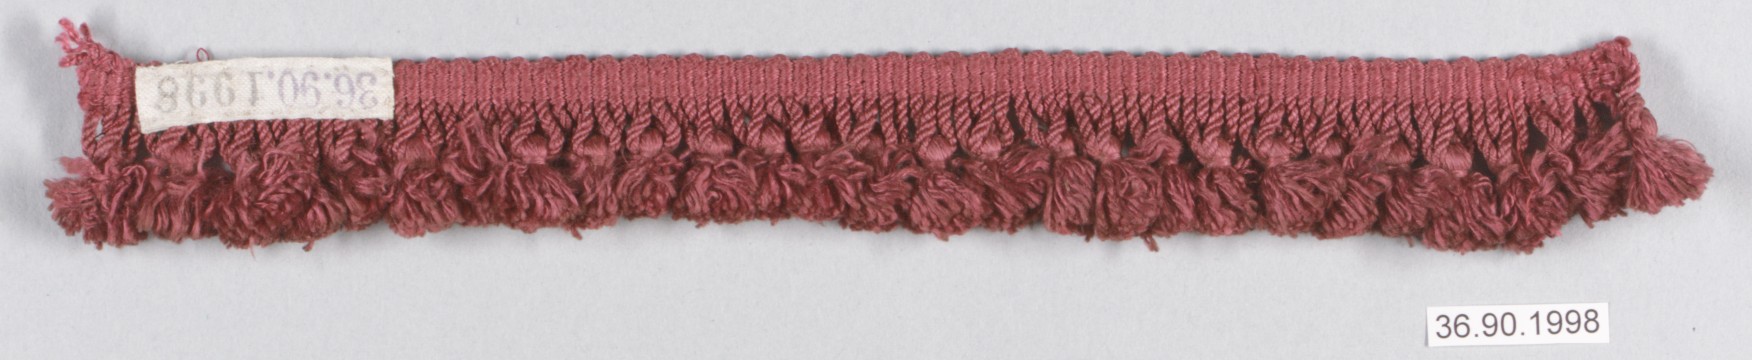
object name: fringe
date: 1801-1833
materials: silk